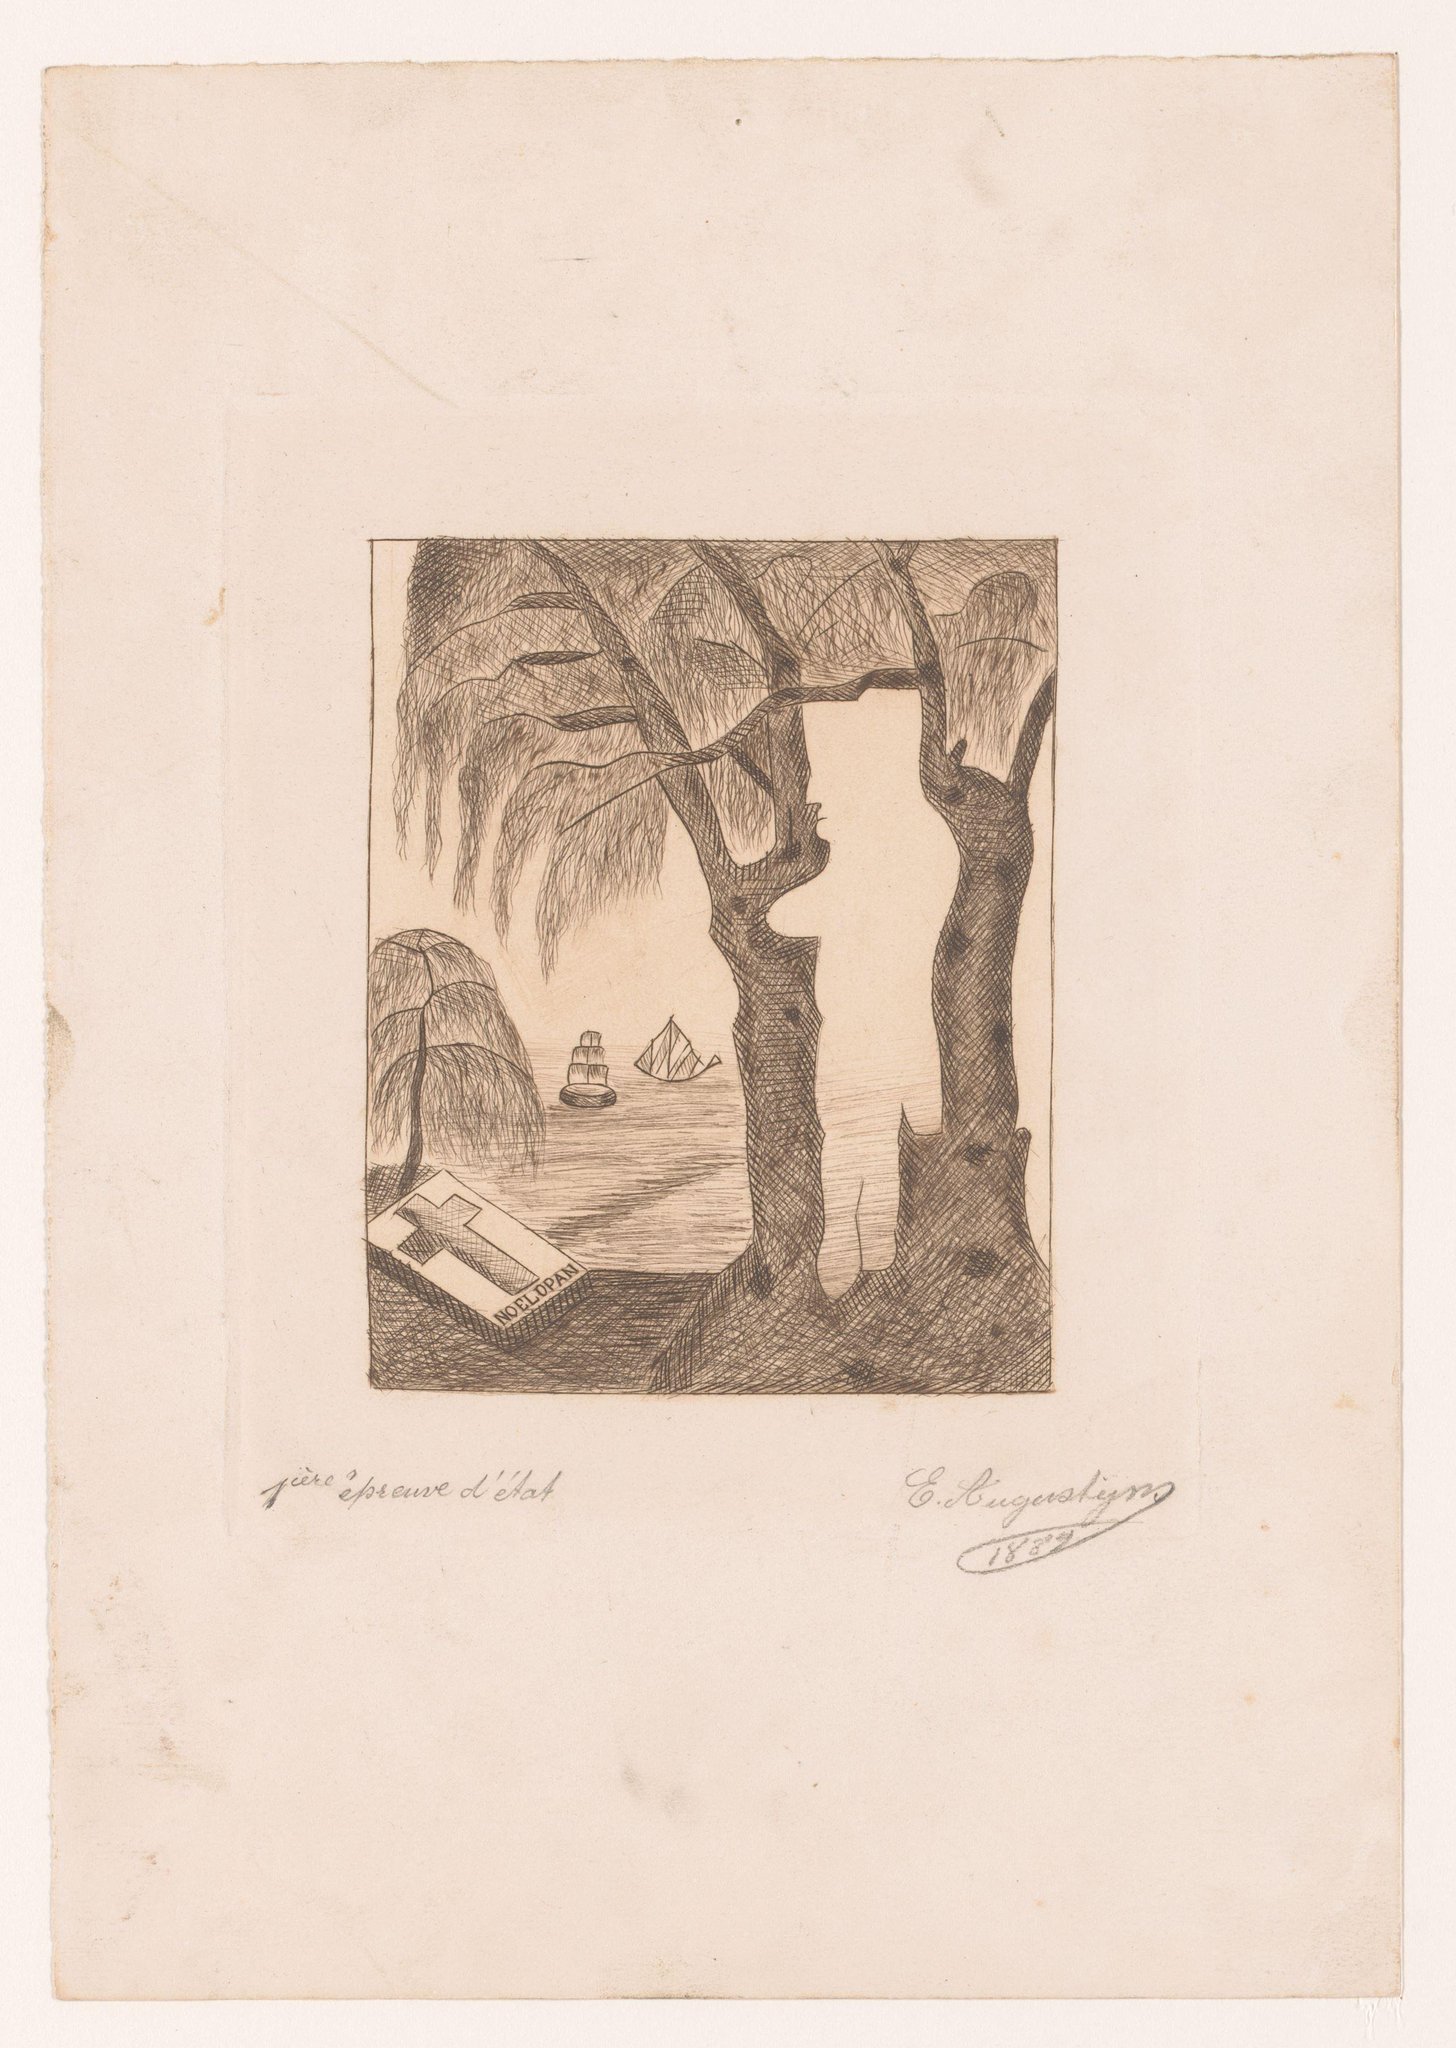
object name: print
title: Graf met daarop de naam van Napoleon in spiegelbeeld, twee zeilboten op de achtergrond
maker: eduard augustyns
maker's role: print maker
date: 1889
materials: paper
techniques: etching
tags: napoleon i (emperor of the french), sailing-ship, sailing-boat, grave, tomb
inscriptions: collector's mark: Lugt 2228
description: Zie RP-P-1909-1583 voor de latere staat, met titel.